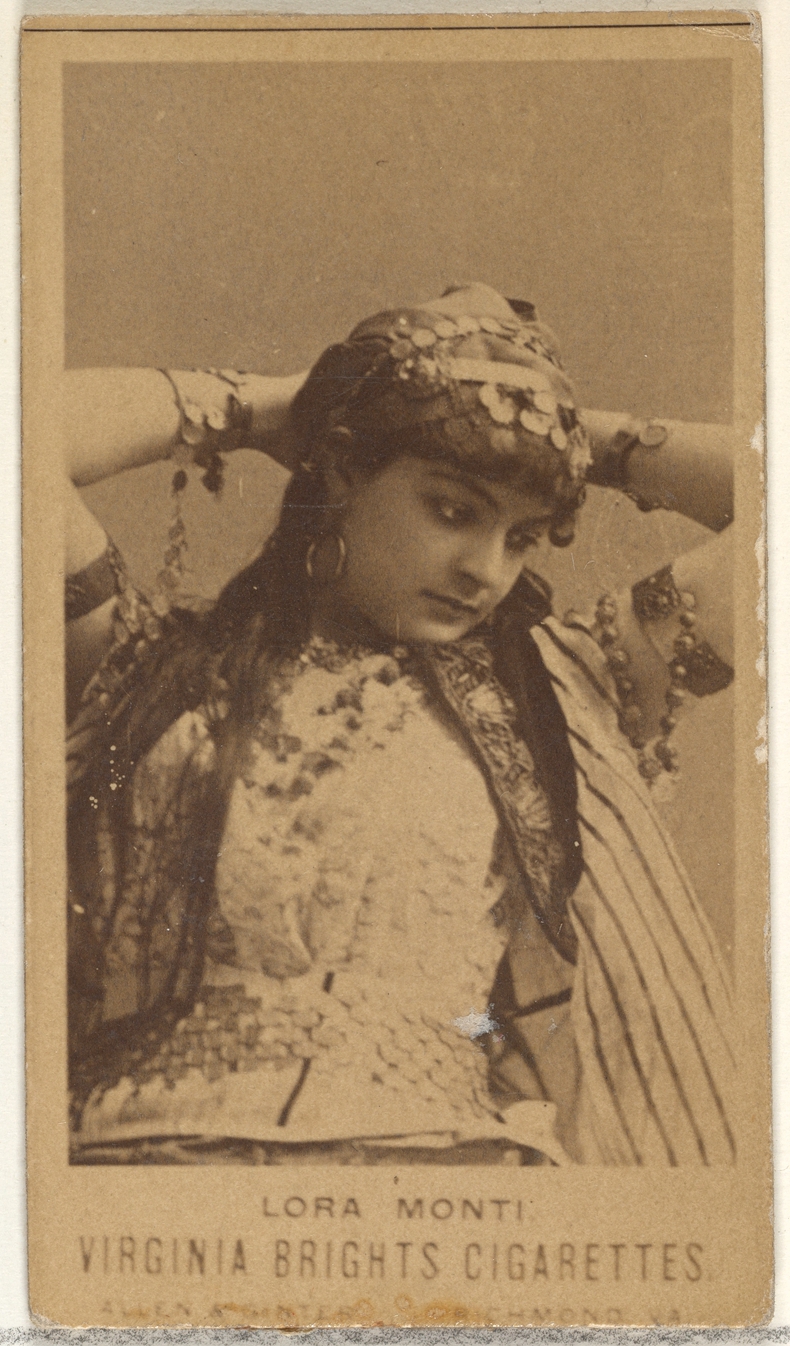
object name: photograph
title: Lora Monti, from the Actors and Actresses series (N45, Type 1) for Virginia Brights Cigarettes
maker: allen & ginter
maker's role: publisher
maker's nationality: american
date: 1888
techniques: albumen silver print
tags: portraits,women,actresses